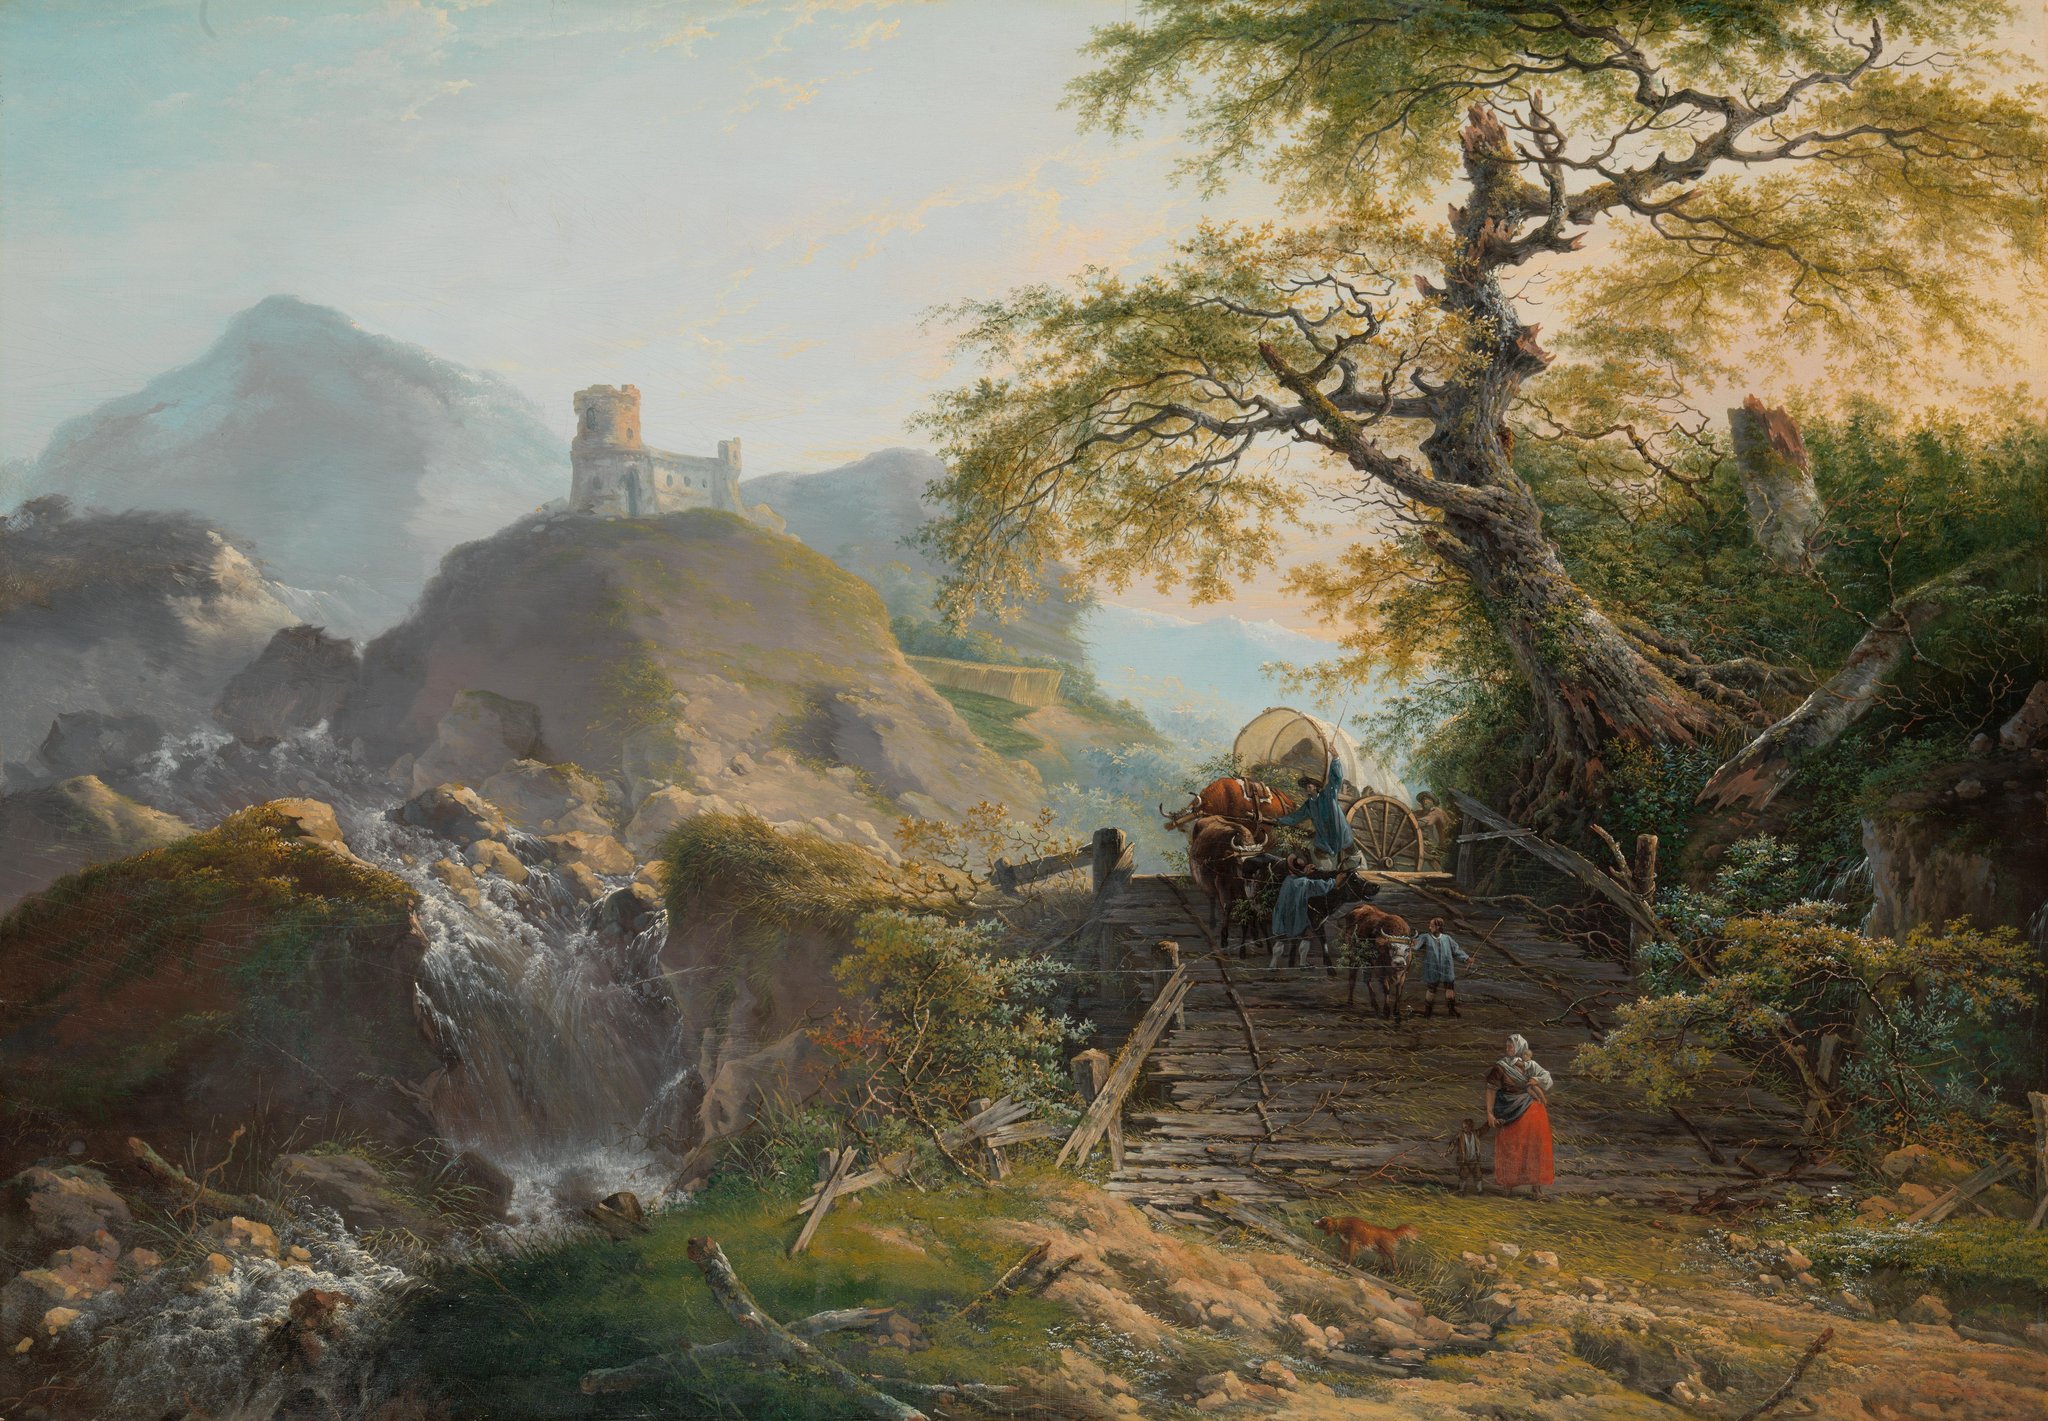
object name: painting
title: Mountainous Landscape near Düsseldorf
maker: gerard van nijmegen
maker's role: draughtsman, painter, print maker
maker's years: 1735-1808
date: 1790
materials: oil, panel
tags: castle, four-wheeled, animal-drawn vehicle, e.g.: cab, carriage, coach, landscape with bridge, viaduct or aqueduct, mountains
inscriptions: signature and date: ‘G. van Nijmegen 1790’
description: This untamed view of nature anticipates picturesque features of Romanticism. Van Nijmegen, though, was also inspired by 17th-century Dutch painters, such as Jacob van Ruisdael. He had seen the subject of this painting – a landscape with ruins and drovers driving an ox-wagon over a wooden bridge – while travelling along the Rhine in 1788. He described it in his journal.